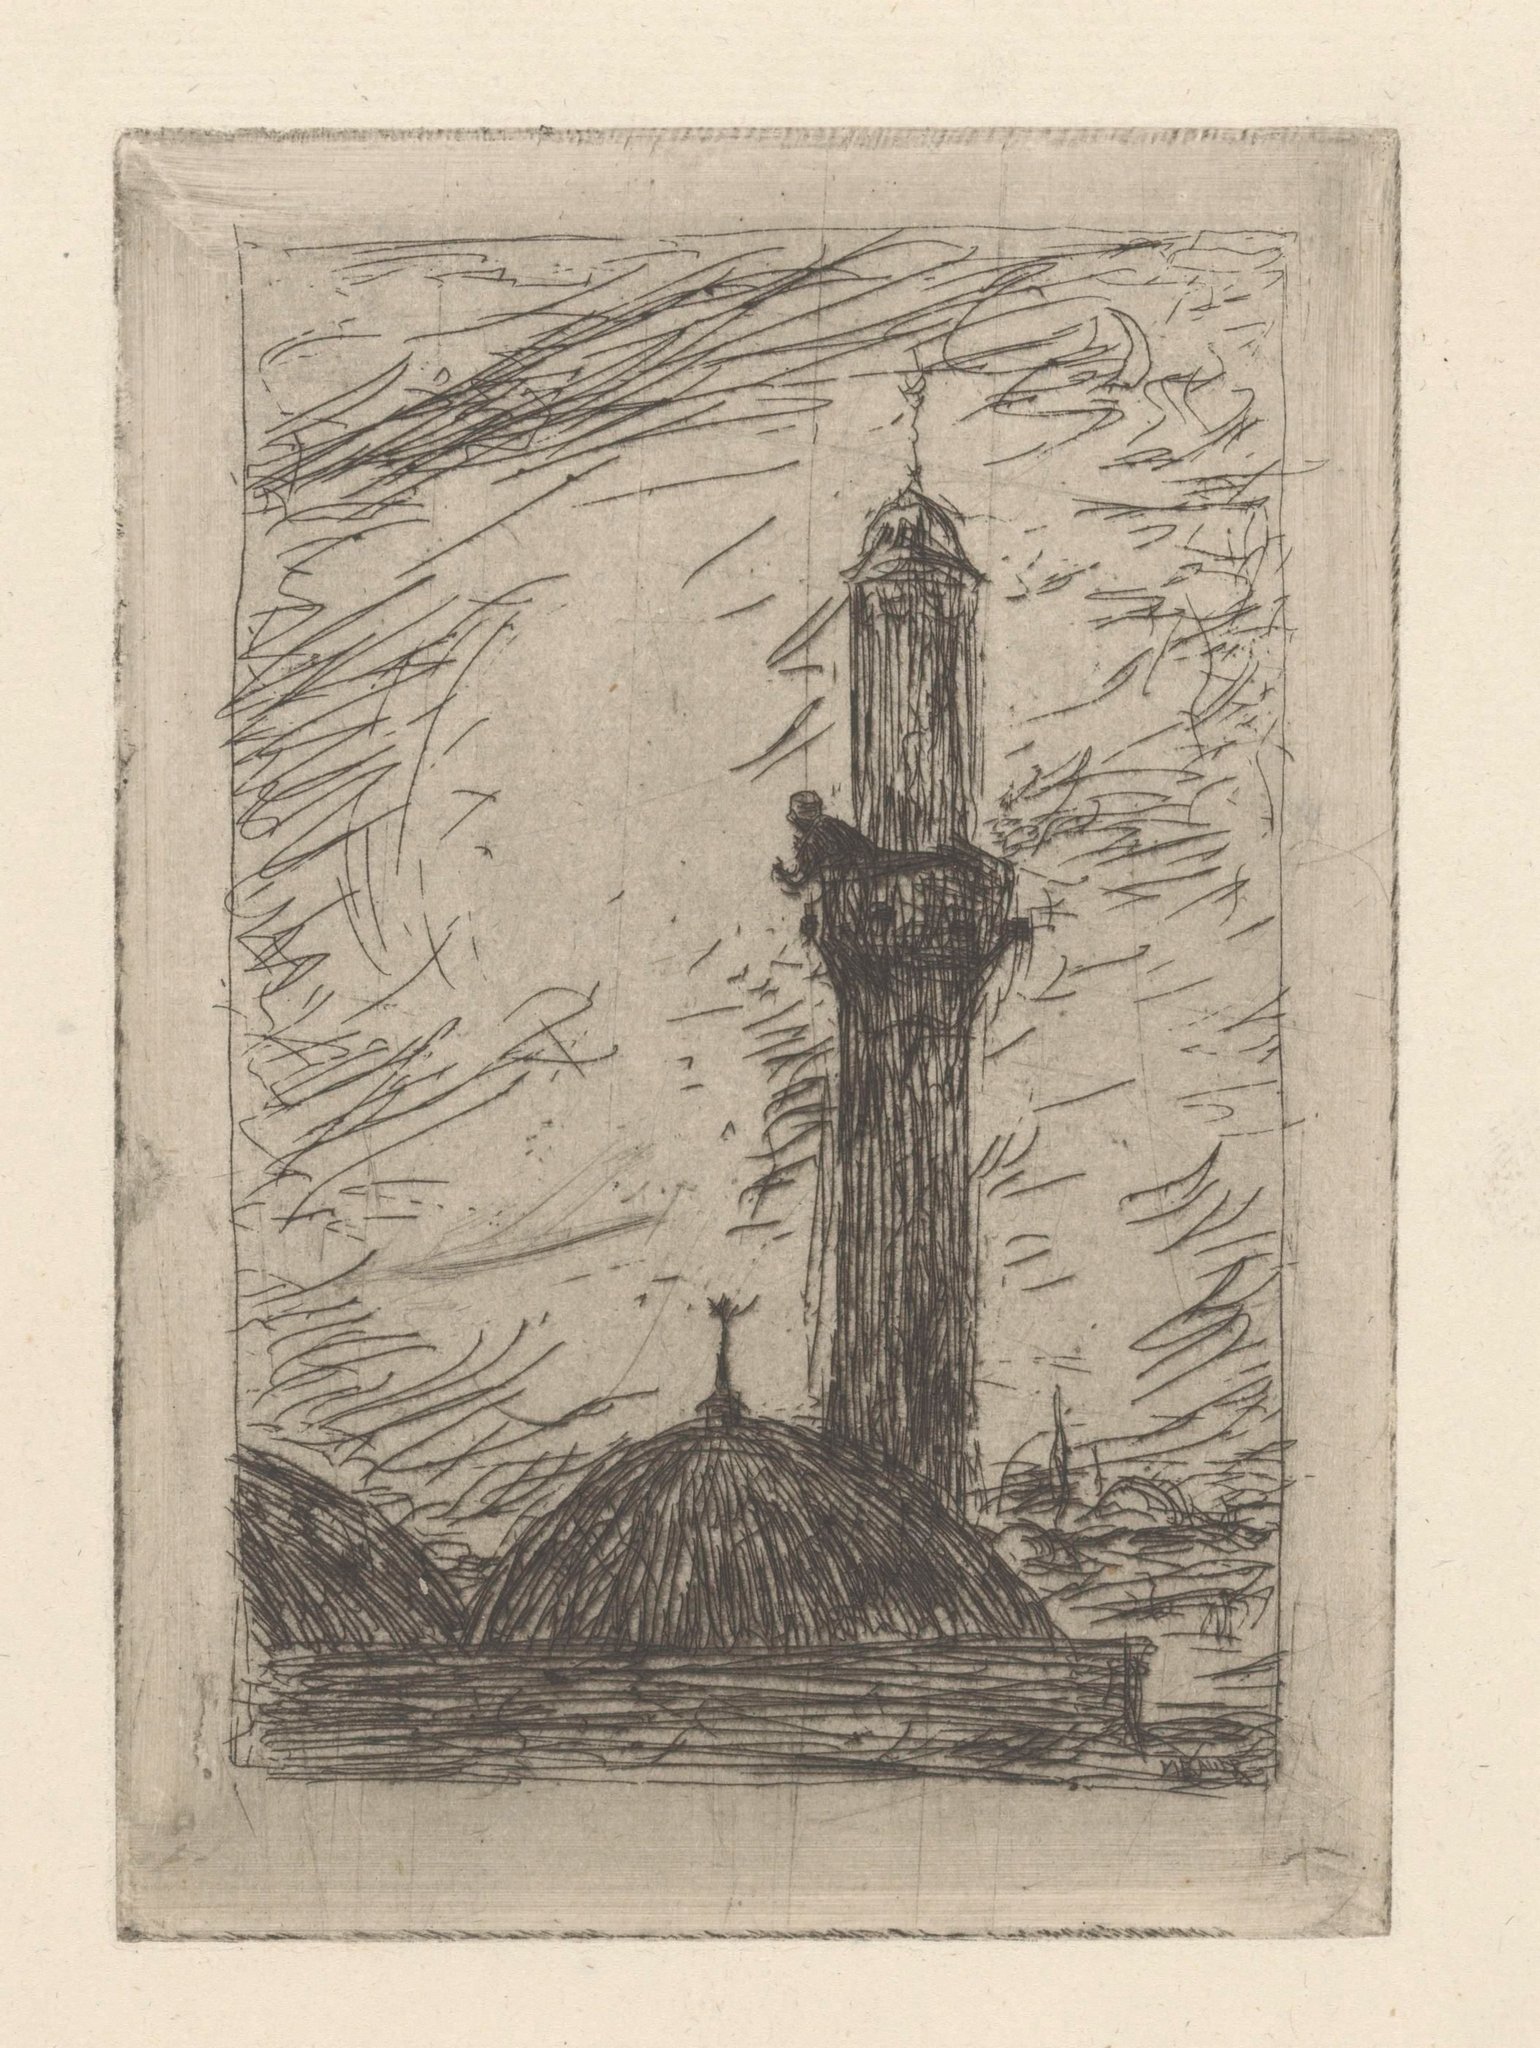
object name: print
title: Minaret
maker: marius bauer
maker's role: draughtsman, print maker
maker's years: 1867-1932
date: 1889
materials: paper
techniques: etching, intaglio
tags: temple, shrine ~ islam, mohammedanism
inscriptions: collector's mark: Lugt 2228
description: Minaret van een moskee met een muezzin die oproept tot het rituele gebed.